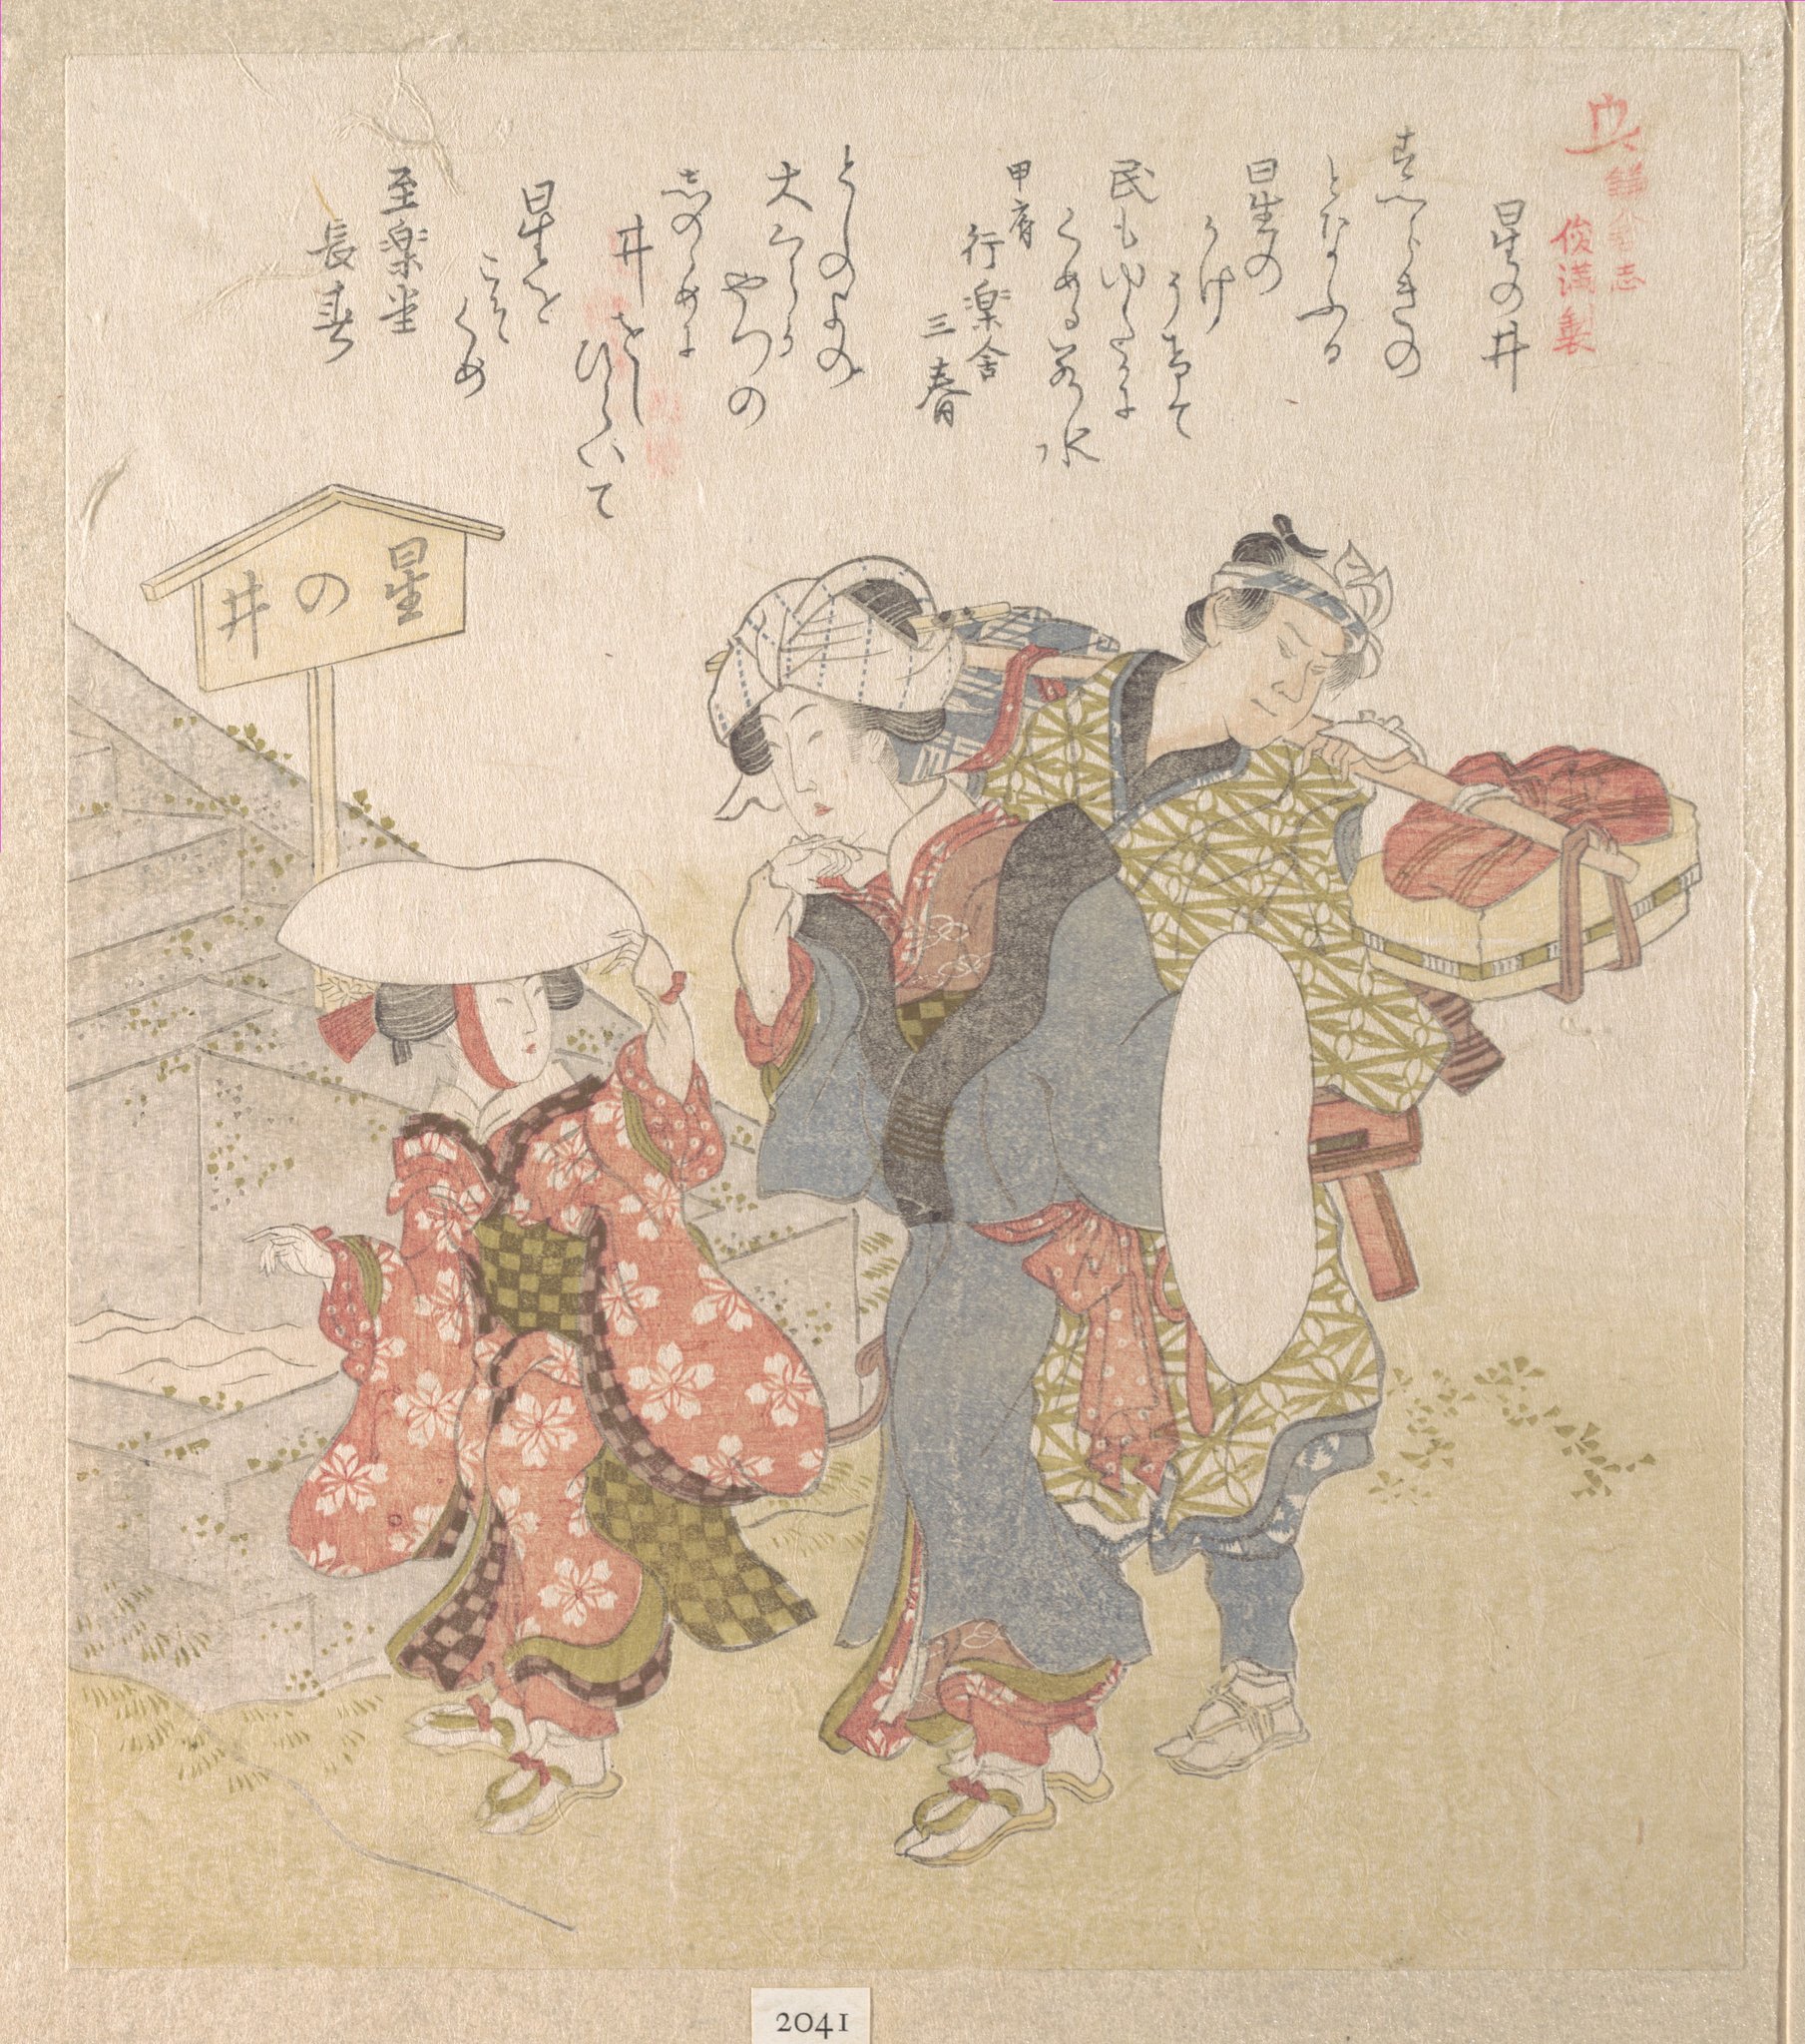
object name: print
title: History of Kamakura: Visitors to Hoshinoi Well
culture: japanese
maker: totoya hokkei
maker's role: artist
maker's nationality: japanese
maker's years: 1780-1850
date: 1801-1900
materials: ink, paper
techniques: surimono, woodblock print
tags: men,women